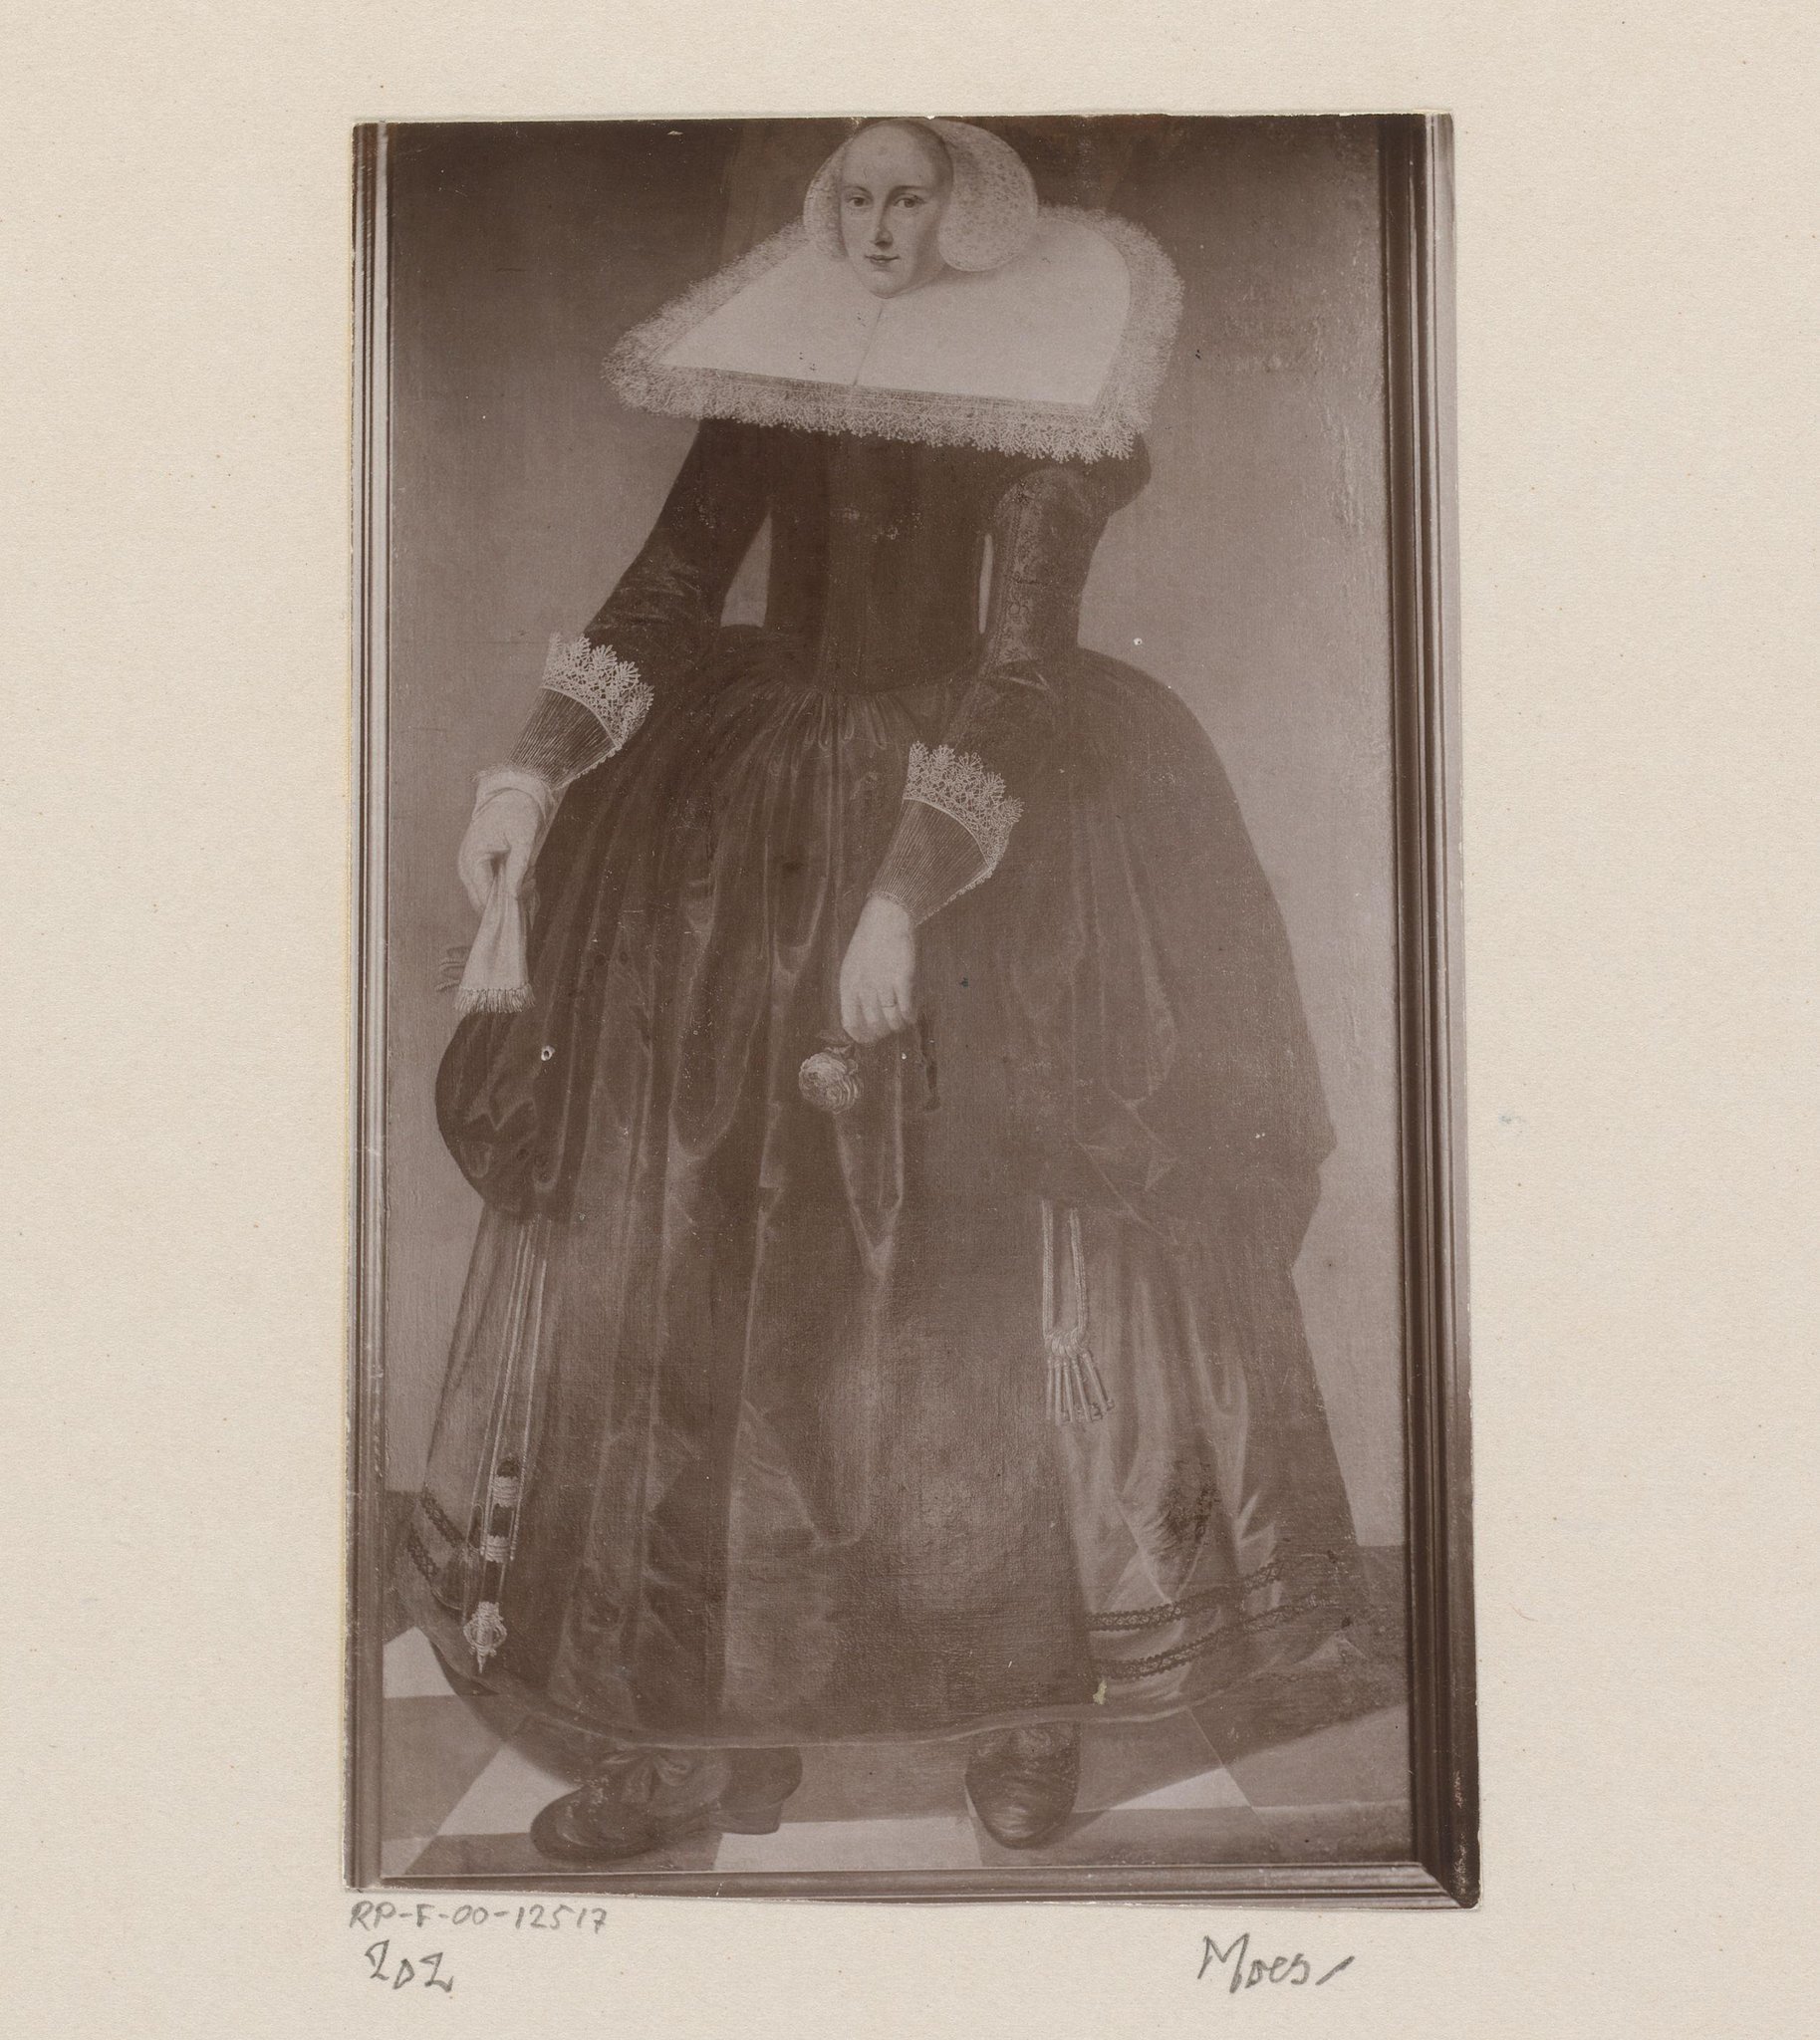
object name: reproduction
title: Fotoreproductie van een geschilderd portret van Trijntje Keever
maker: Anonymous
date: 1890-1930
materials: paper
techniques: gelatin silver print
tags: historical persons - bb - woman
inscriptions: inscription: ‘Naar de schilderij op het stad/ huis te Edam./ Trijntje Cornelis te Keever/ bijgenaamd "de Grote Meydt"/ Aan den voet staat:/ T.C./ Aetatis Suae 17/ To 1633.’